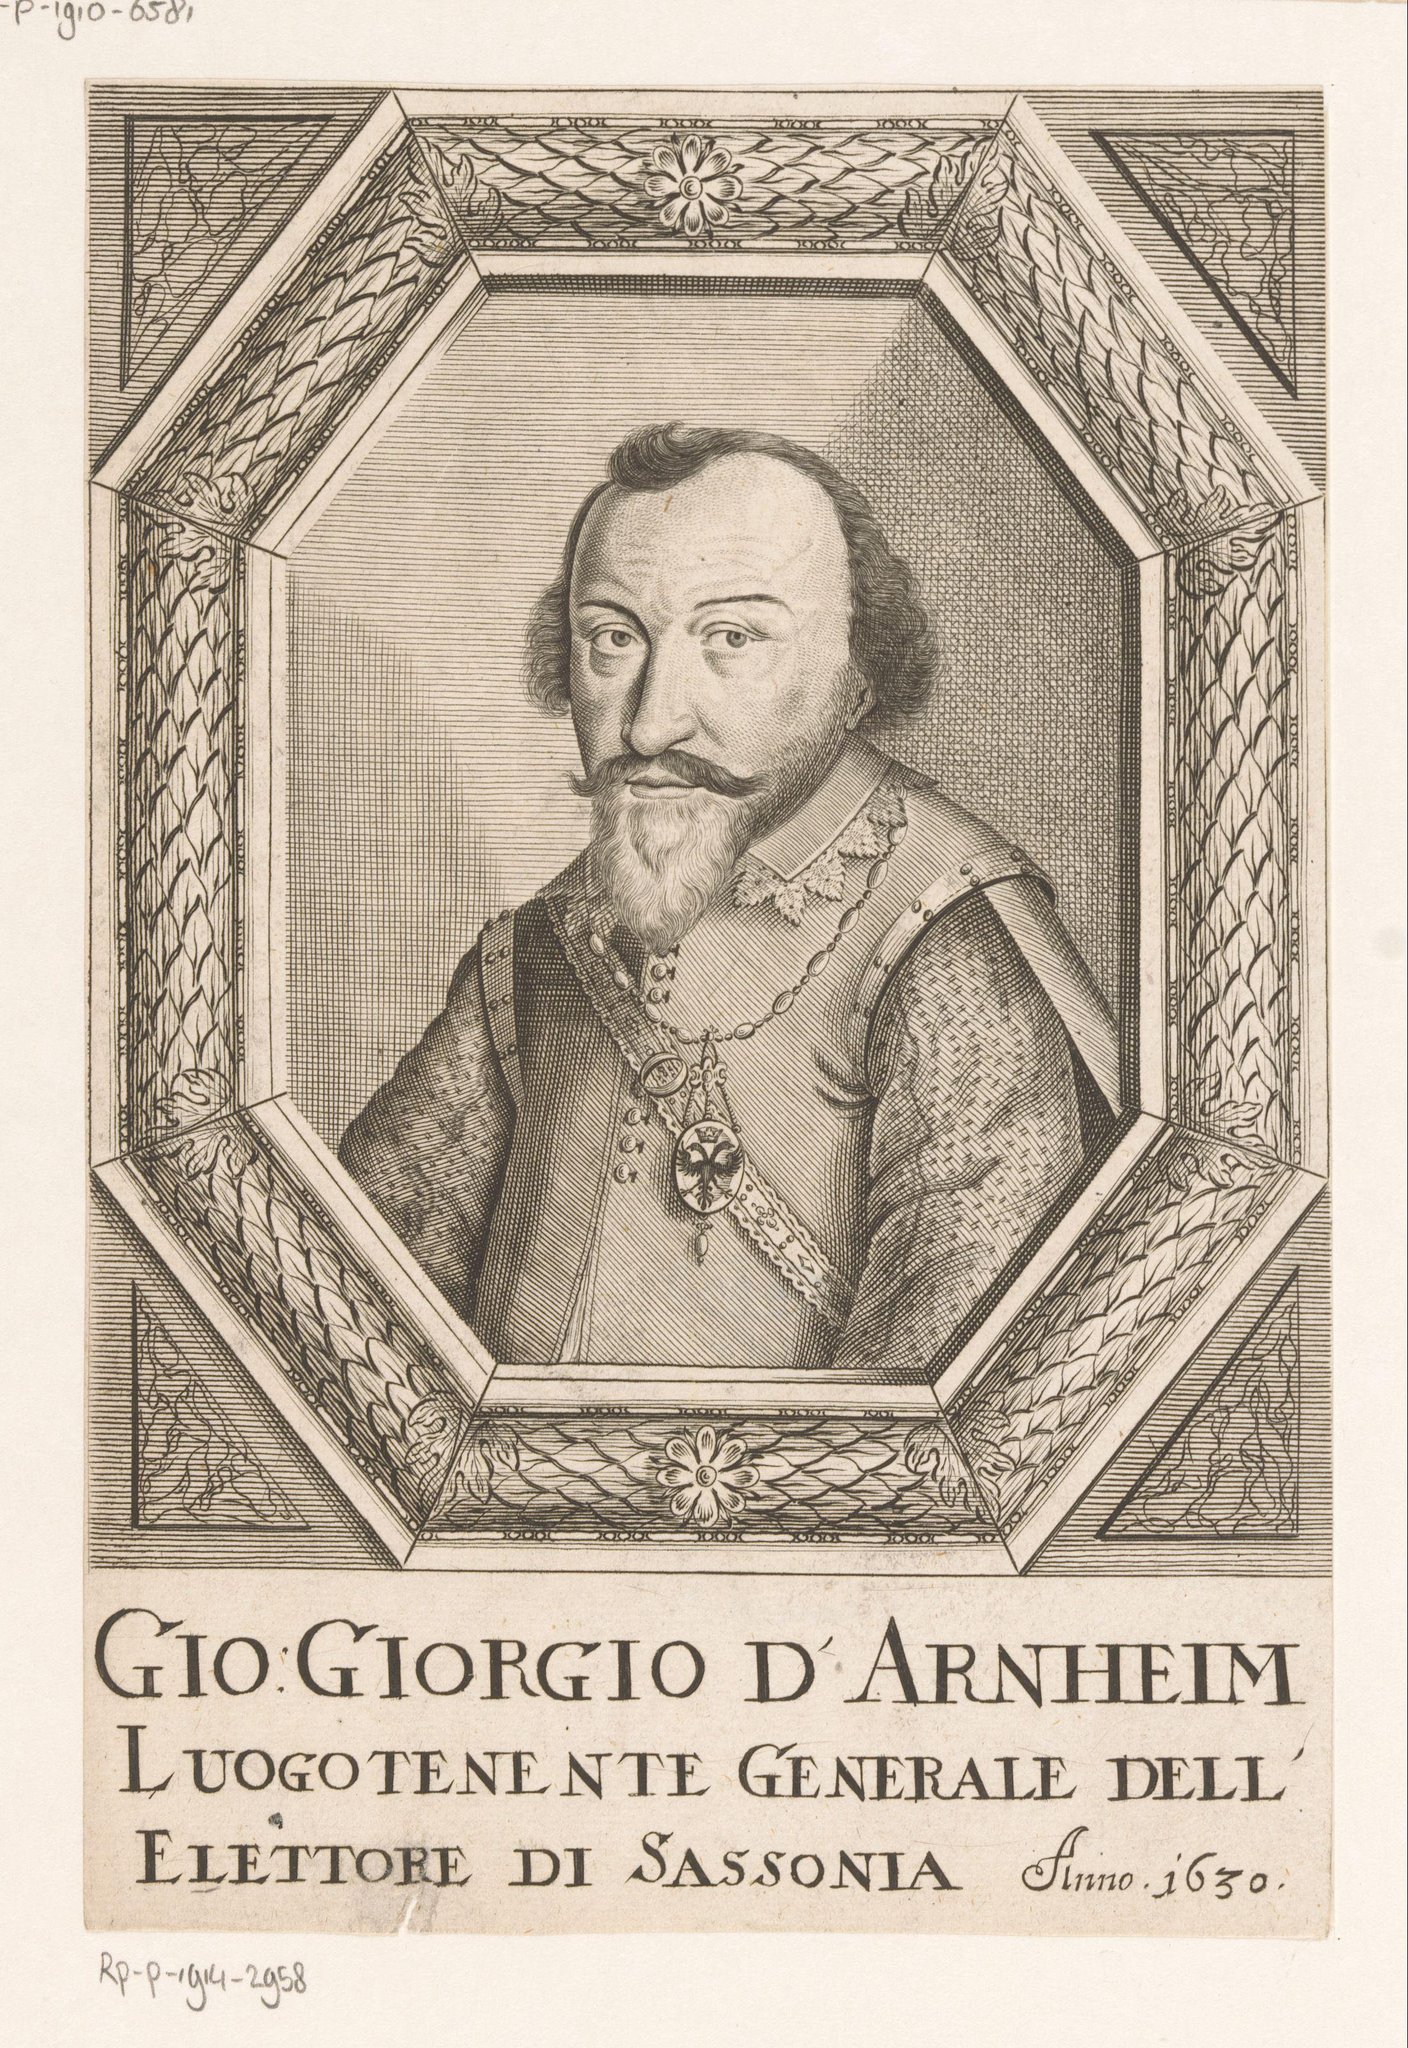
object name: print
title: Portret van Hans Georg Arnim von Boitzenburg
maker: johann franck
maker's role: print maker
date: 1630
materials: paper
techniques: engraving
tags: double-headed eagle, historical persons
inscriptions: collector's mark: Lugt 2228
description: Prent gebruikt voor: Priorato, Galeazzo Gualdo. Historia di Ferdinando terzo. Wenen: s.n., 1672.